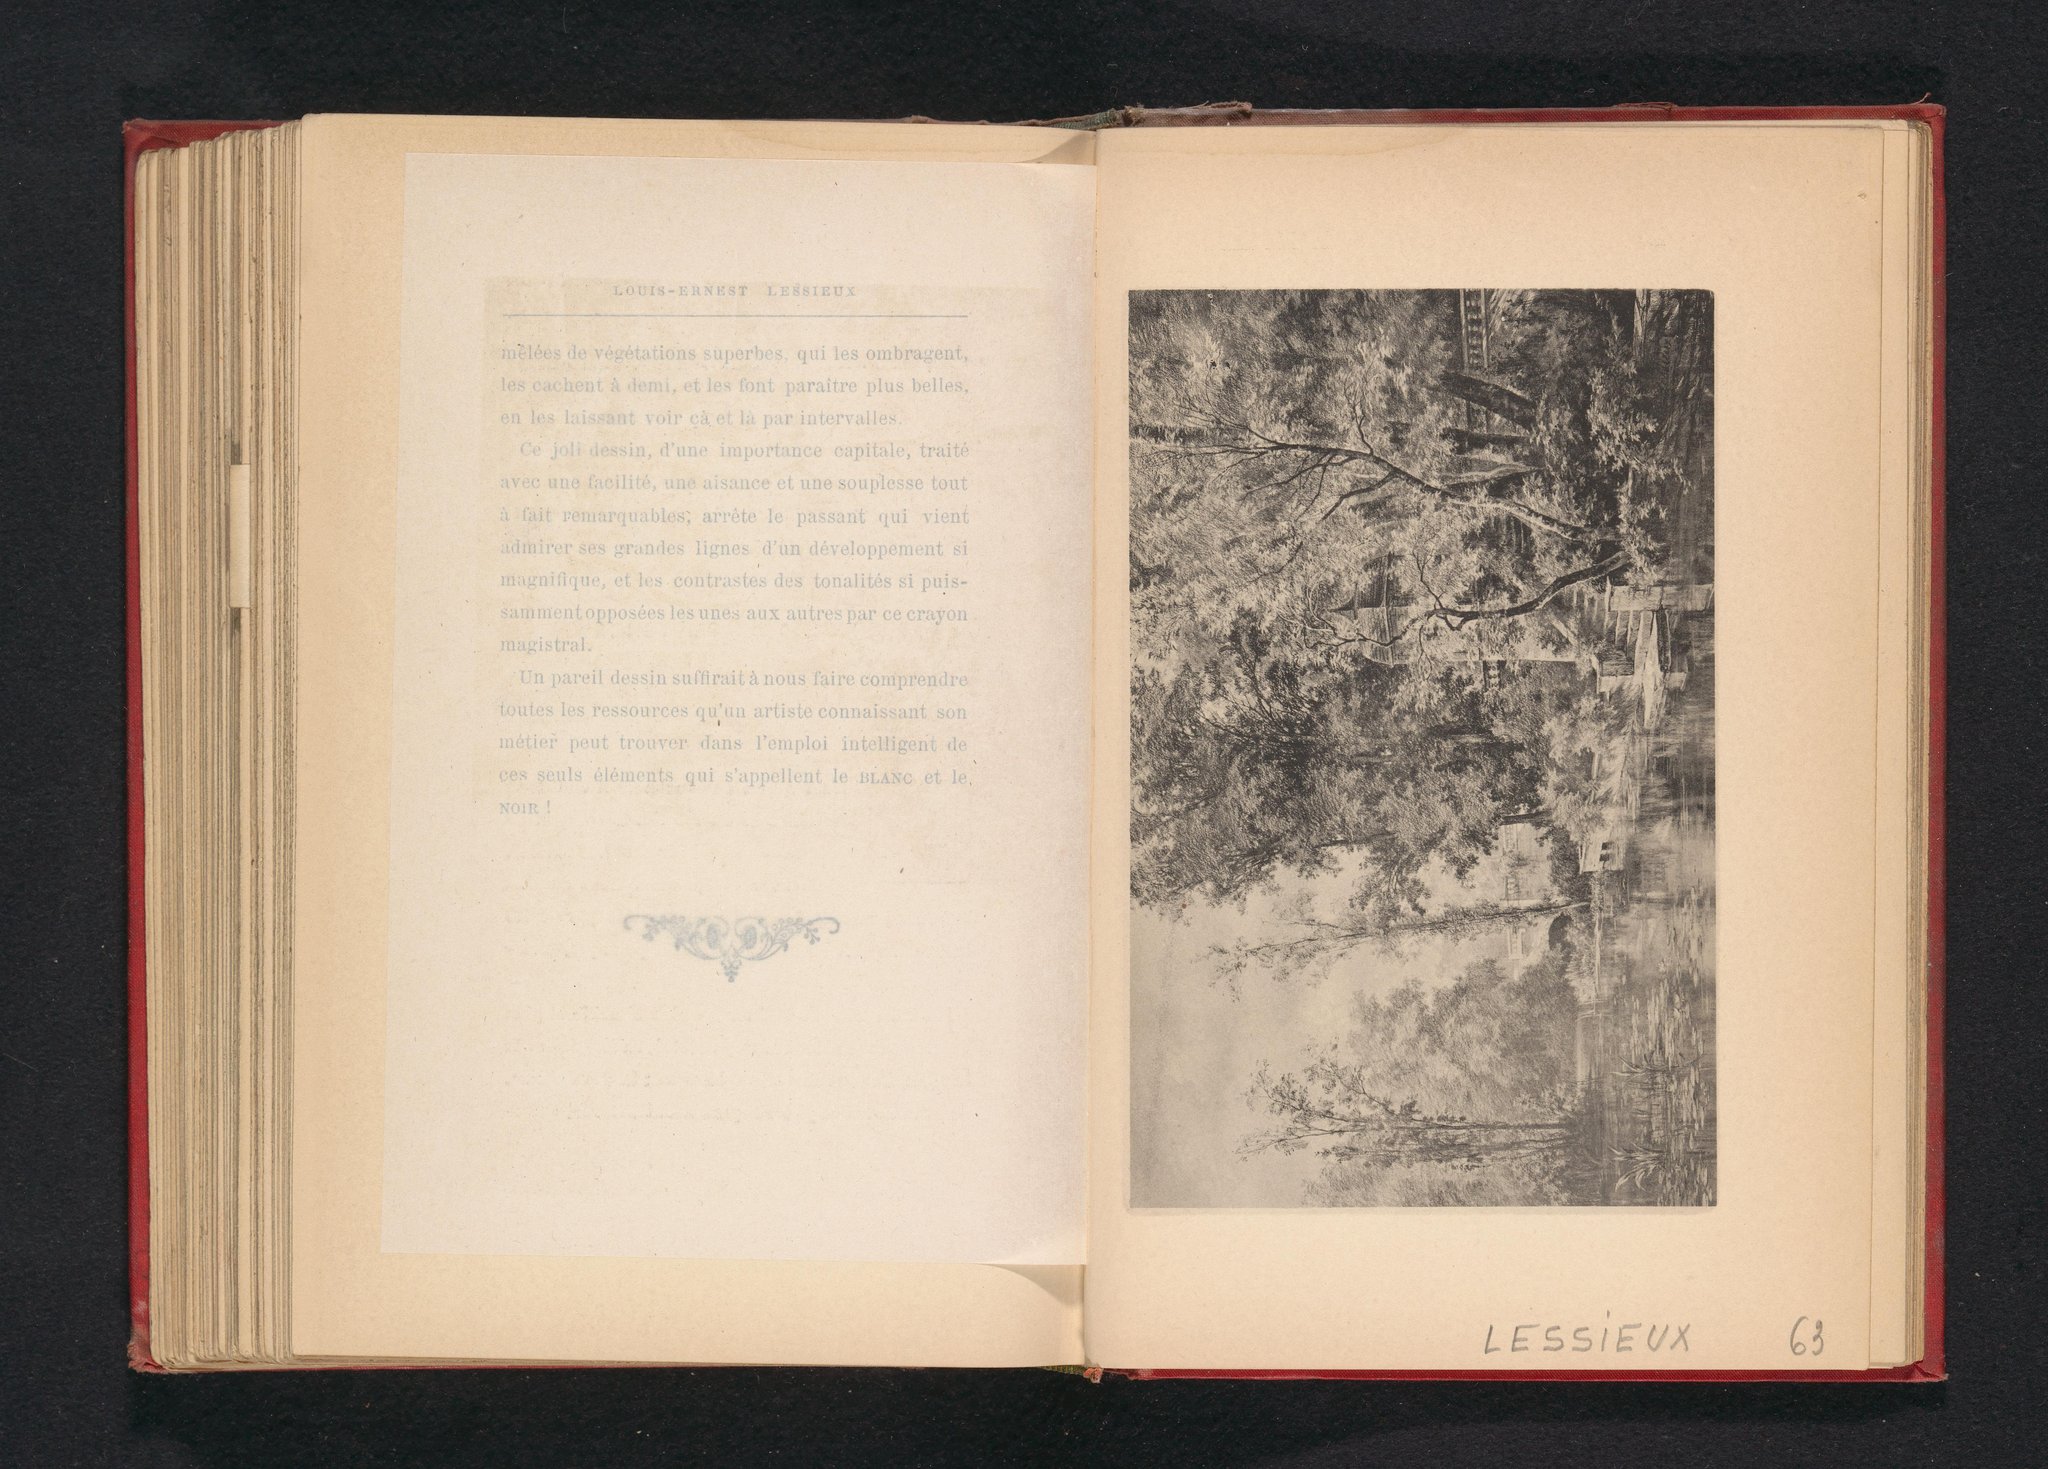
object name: page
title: Fotoreproductie van een schilderij, voorstellende een park langs een rivier te Saintonge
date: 1872-1882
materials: paper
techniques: photograph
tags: park, river